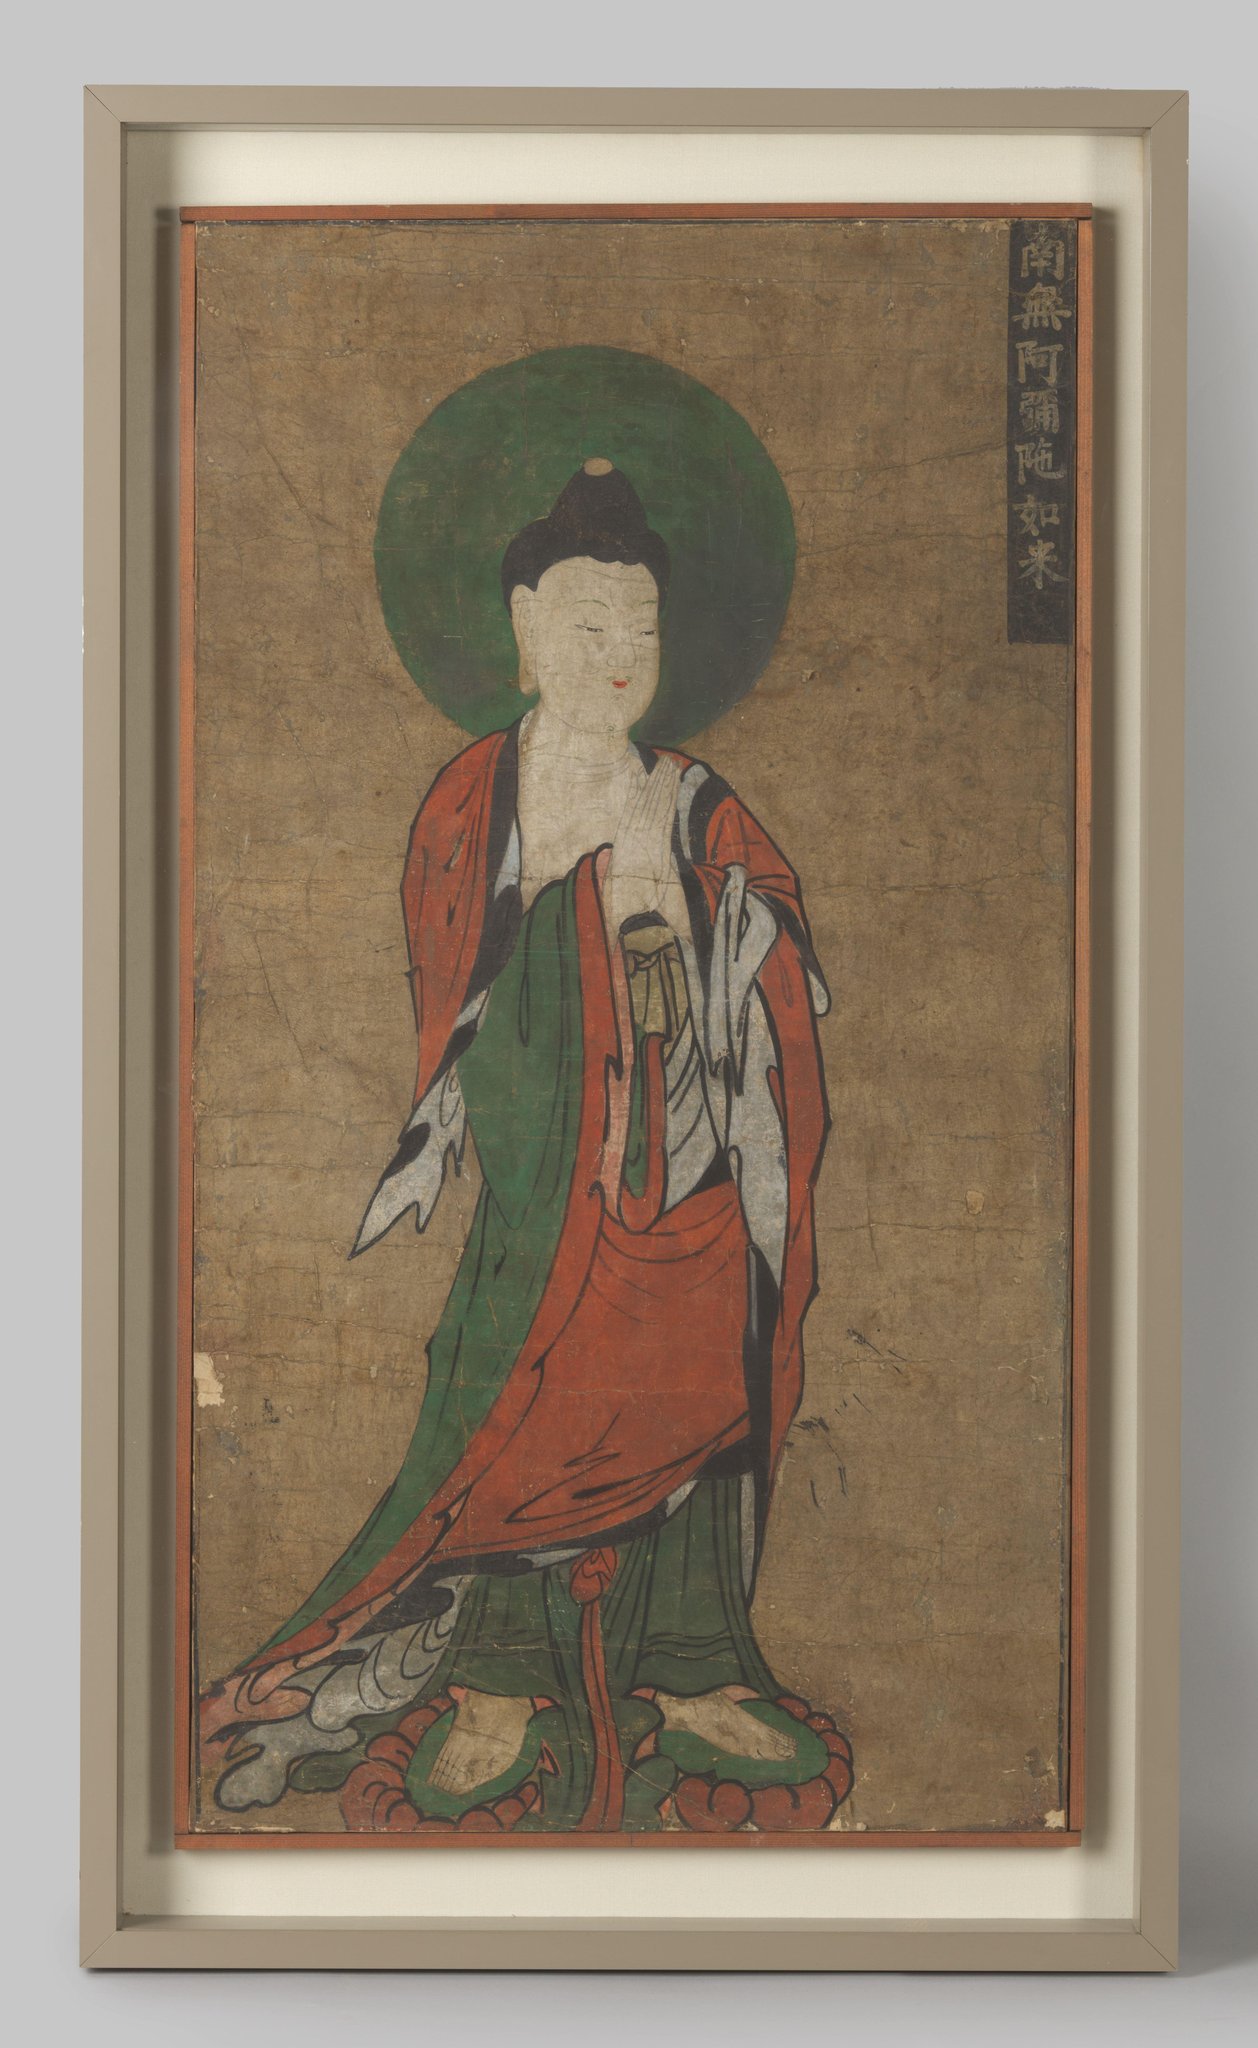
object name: boeddha kop, boeddha beeld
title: Boeddha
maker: Anonymous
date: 1400-1500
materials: dye, ink, paper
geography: korea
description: Schildering, Boeddha Amitabha. Korea, Amida 15de eeuw